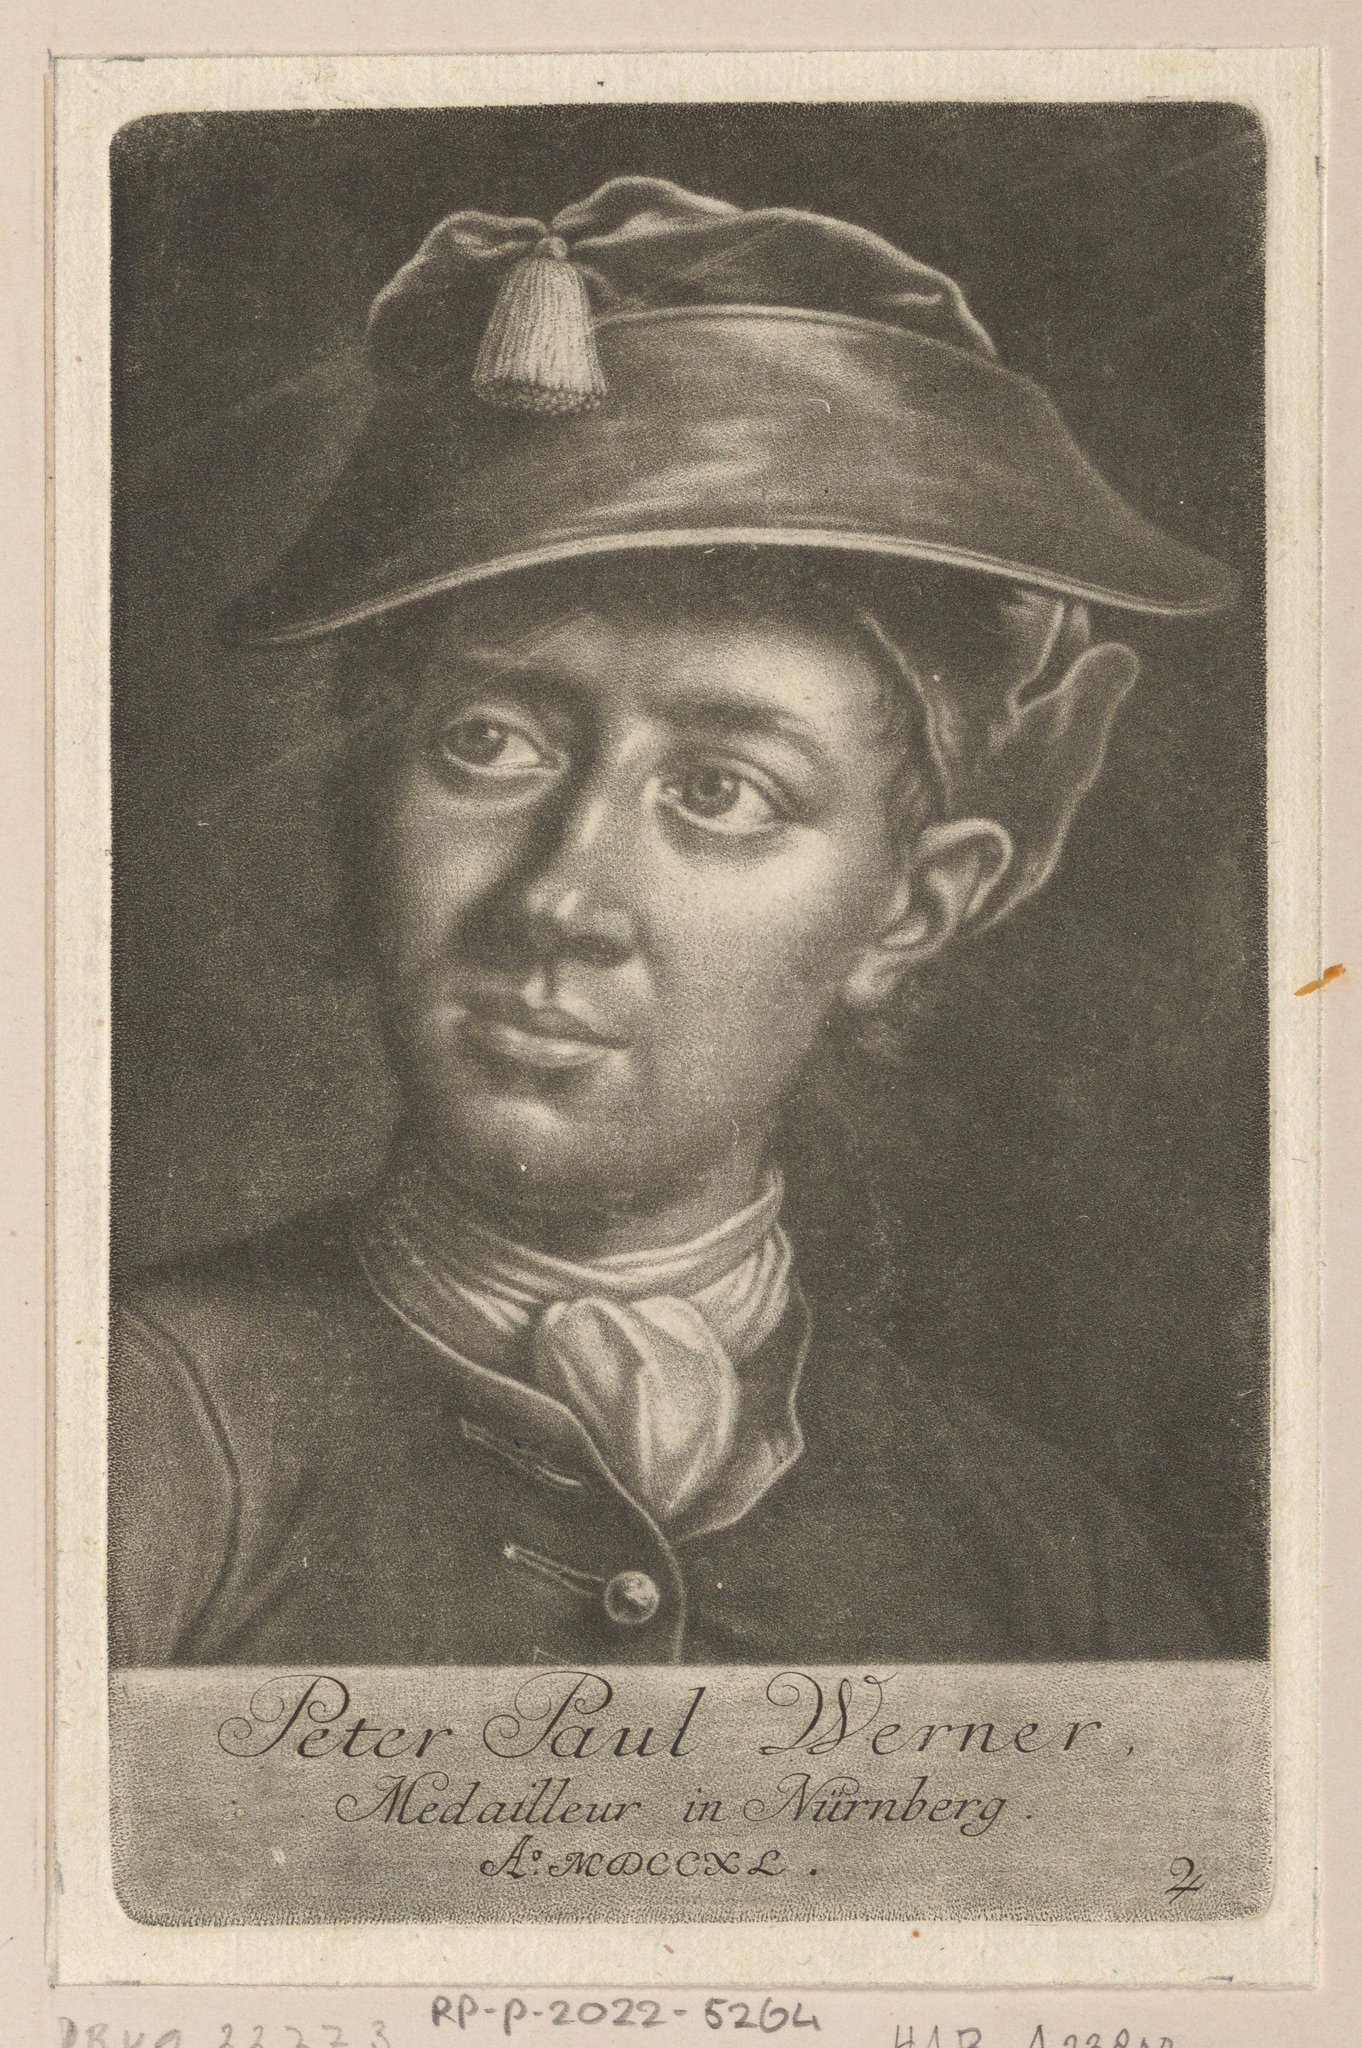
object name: print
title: Portret van Peter Paul Werner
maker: bernhard vogel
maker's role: draughtsman, painter, print maker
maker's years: 1683-1737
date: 1740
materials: paper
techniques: engraving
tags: peter paul werner, historical persons